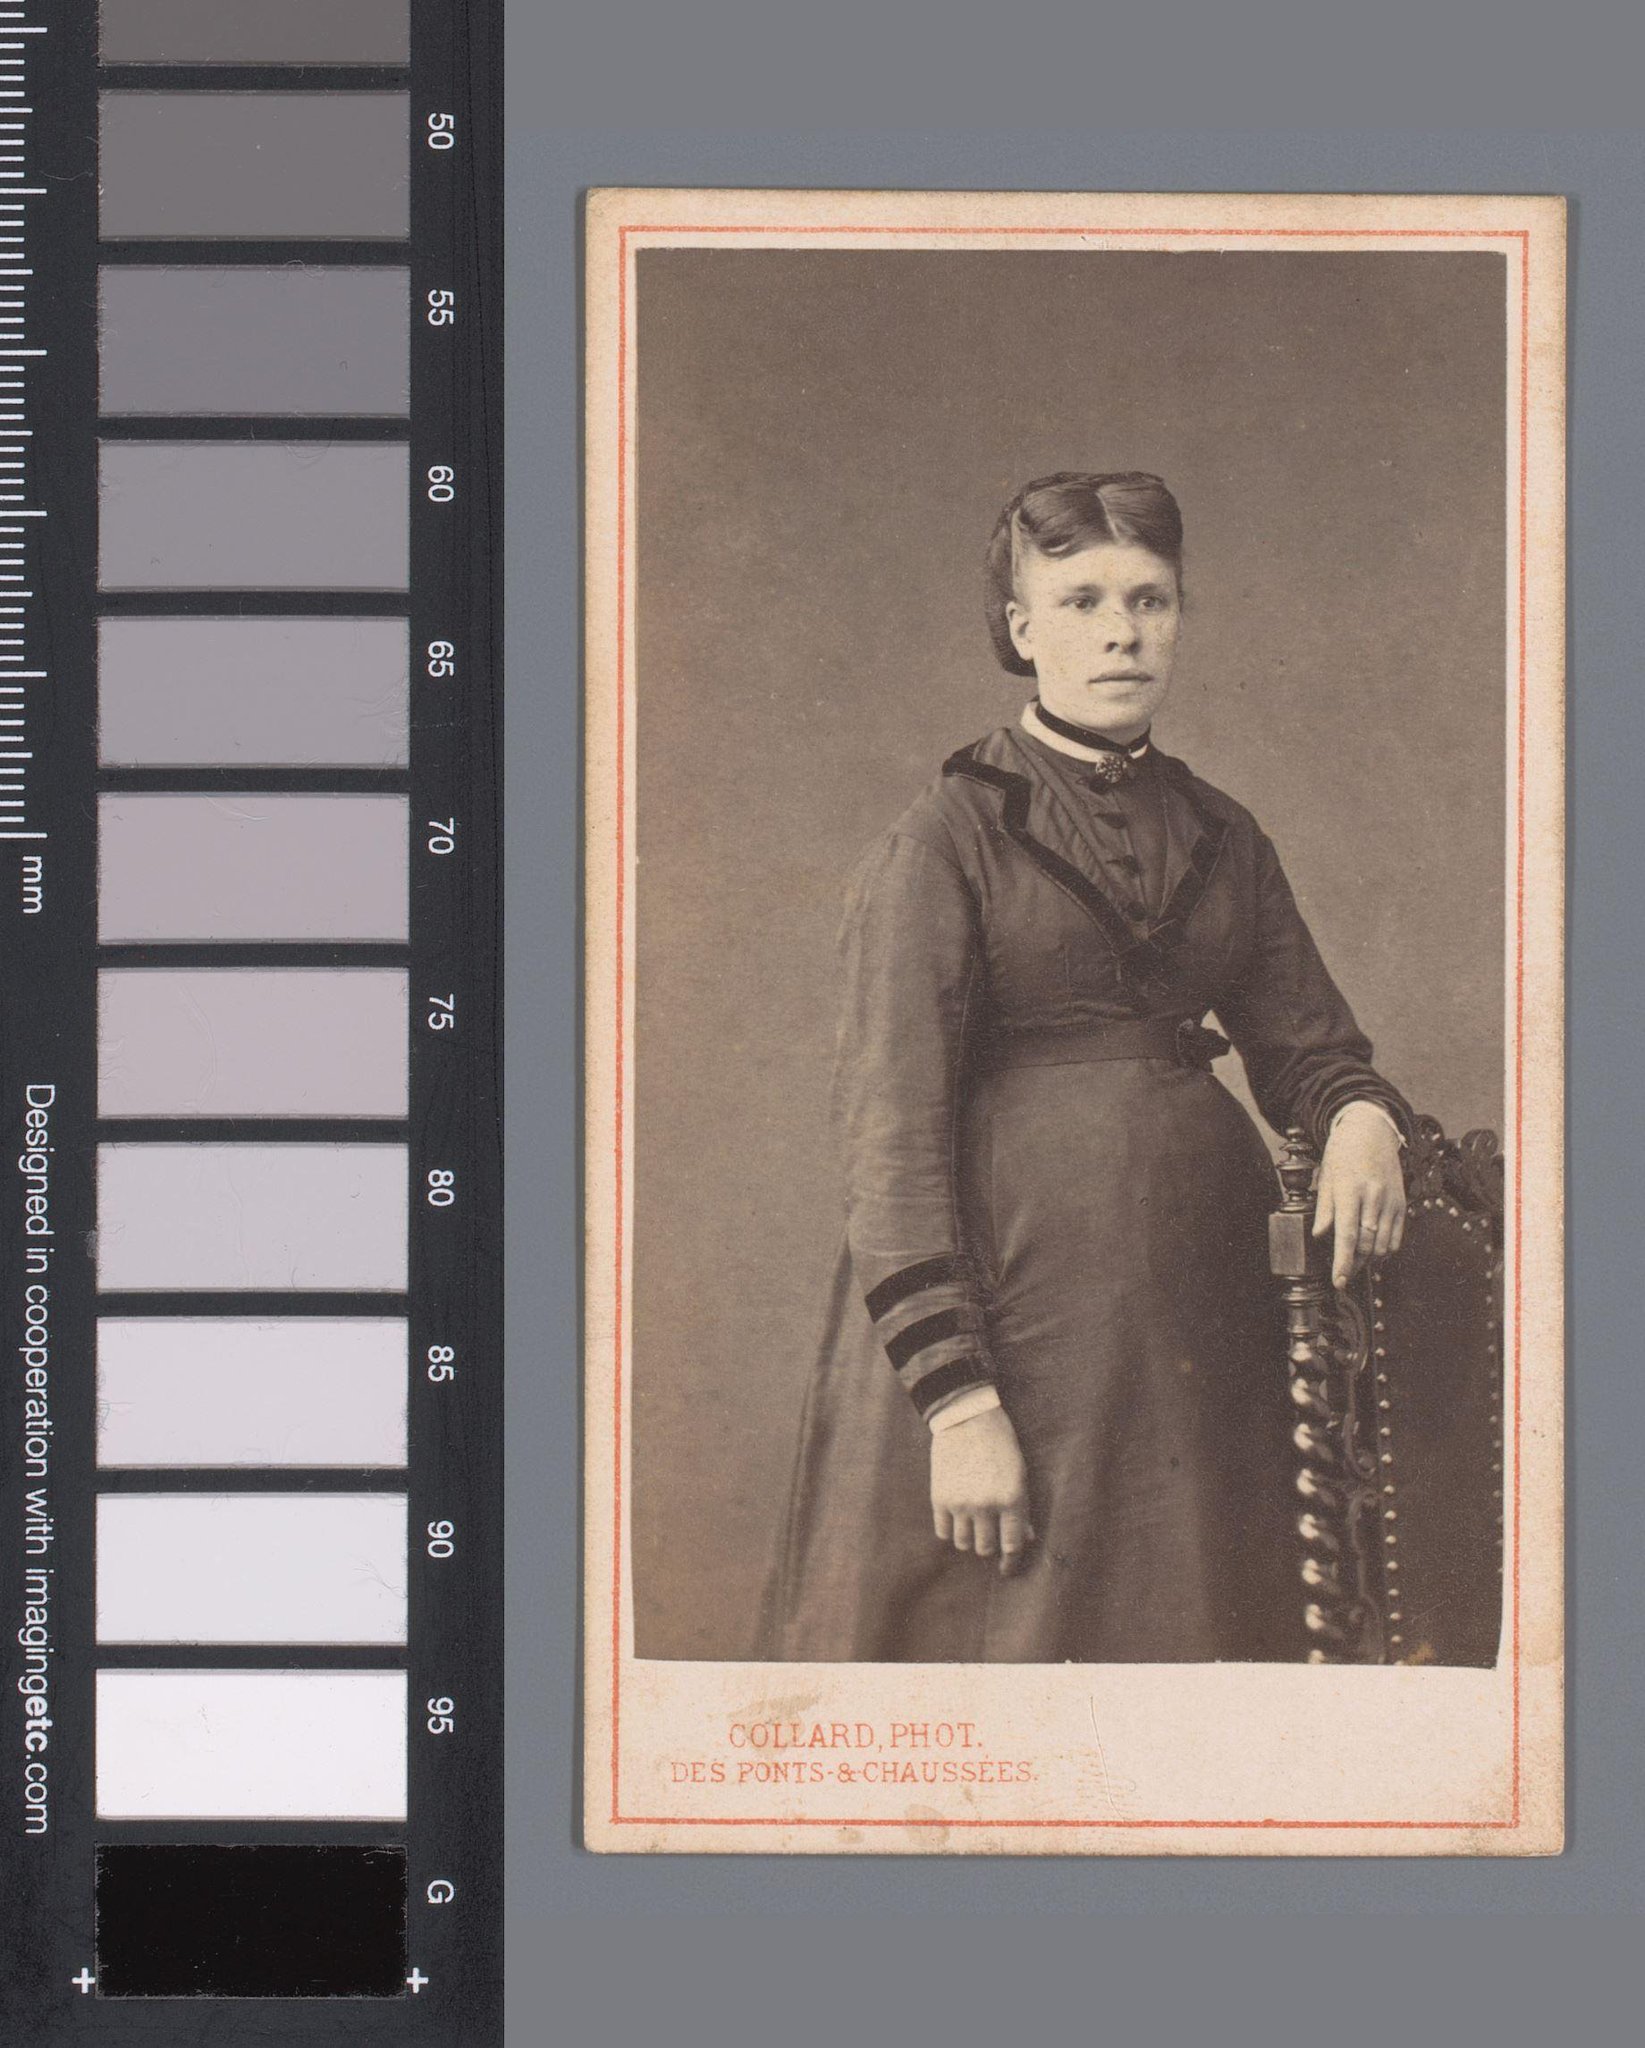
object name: photograph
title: Portret van een onbekende zwangere vrouw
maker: auguste hippolyte collard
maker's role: fotograaf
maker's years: 1812-1887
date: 1867-1880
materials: cardboard, paper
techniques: albumen print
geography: paris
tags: anonymous historical person portrayed, pregnant woman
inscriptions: inscription: ‘EXPOSITIONS UNIVERSELLES 1855, 1867,/ LONDRES 1862./ MENTION HONORABLE/ ATELIER CENTRAL DE PHOTOGRAPHIE/ COLLARD’, address: ‘39, Boulevard de Strasbourg,/ PARIS.’